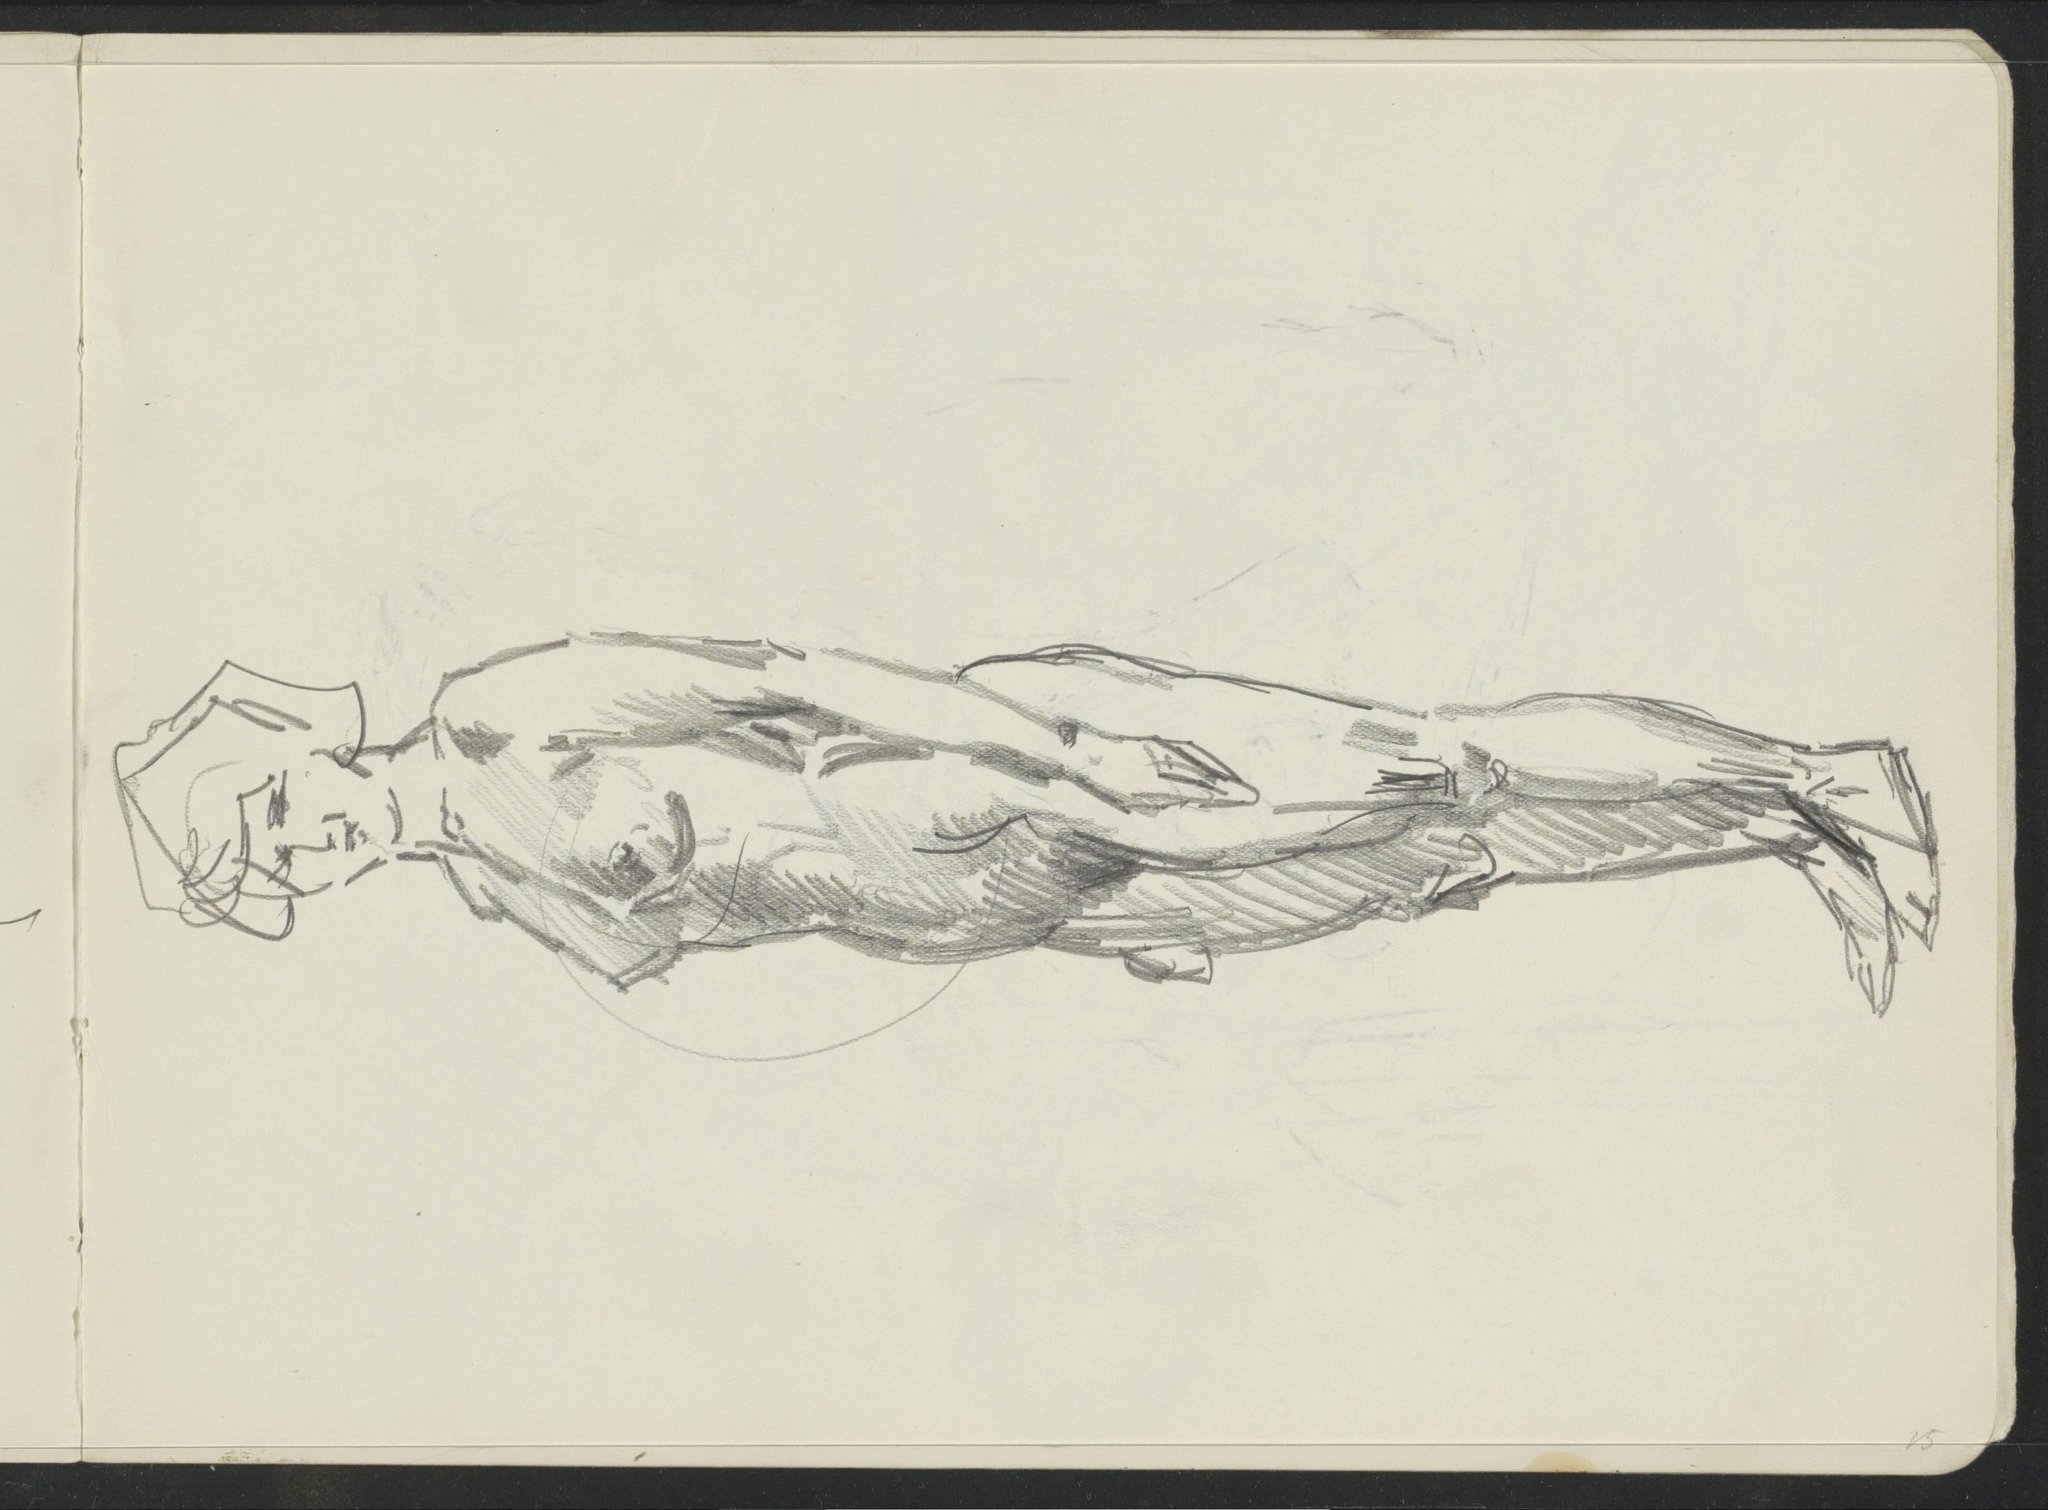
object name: sketchbook leaf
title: Standing Female Nude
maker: isaac israels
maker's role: draughtsman, painter, print maker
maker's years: 1865-1934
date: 1915-1934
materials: paper, pencil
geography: the hague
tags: standing figure - aa - female human figure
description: Blad 15 recto uit schetsboek XV met 22 bladen.